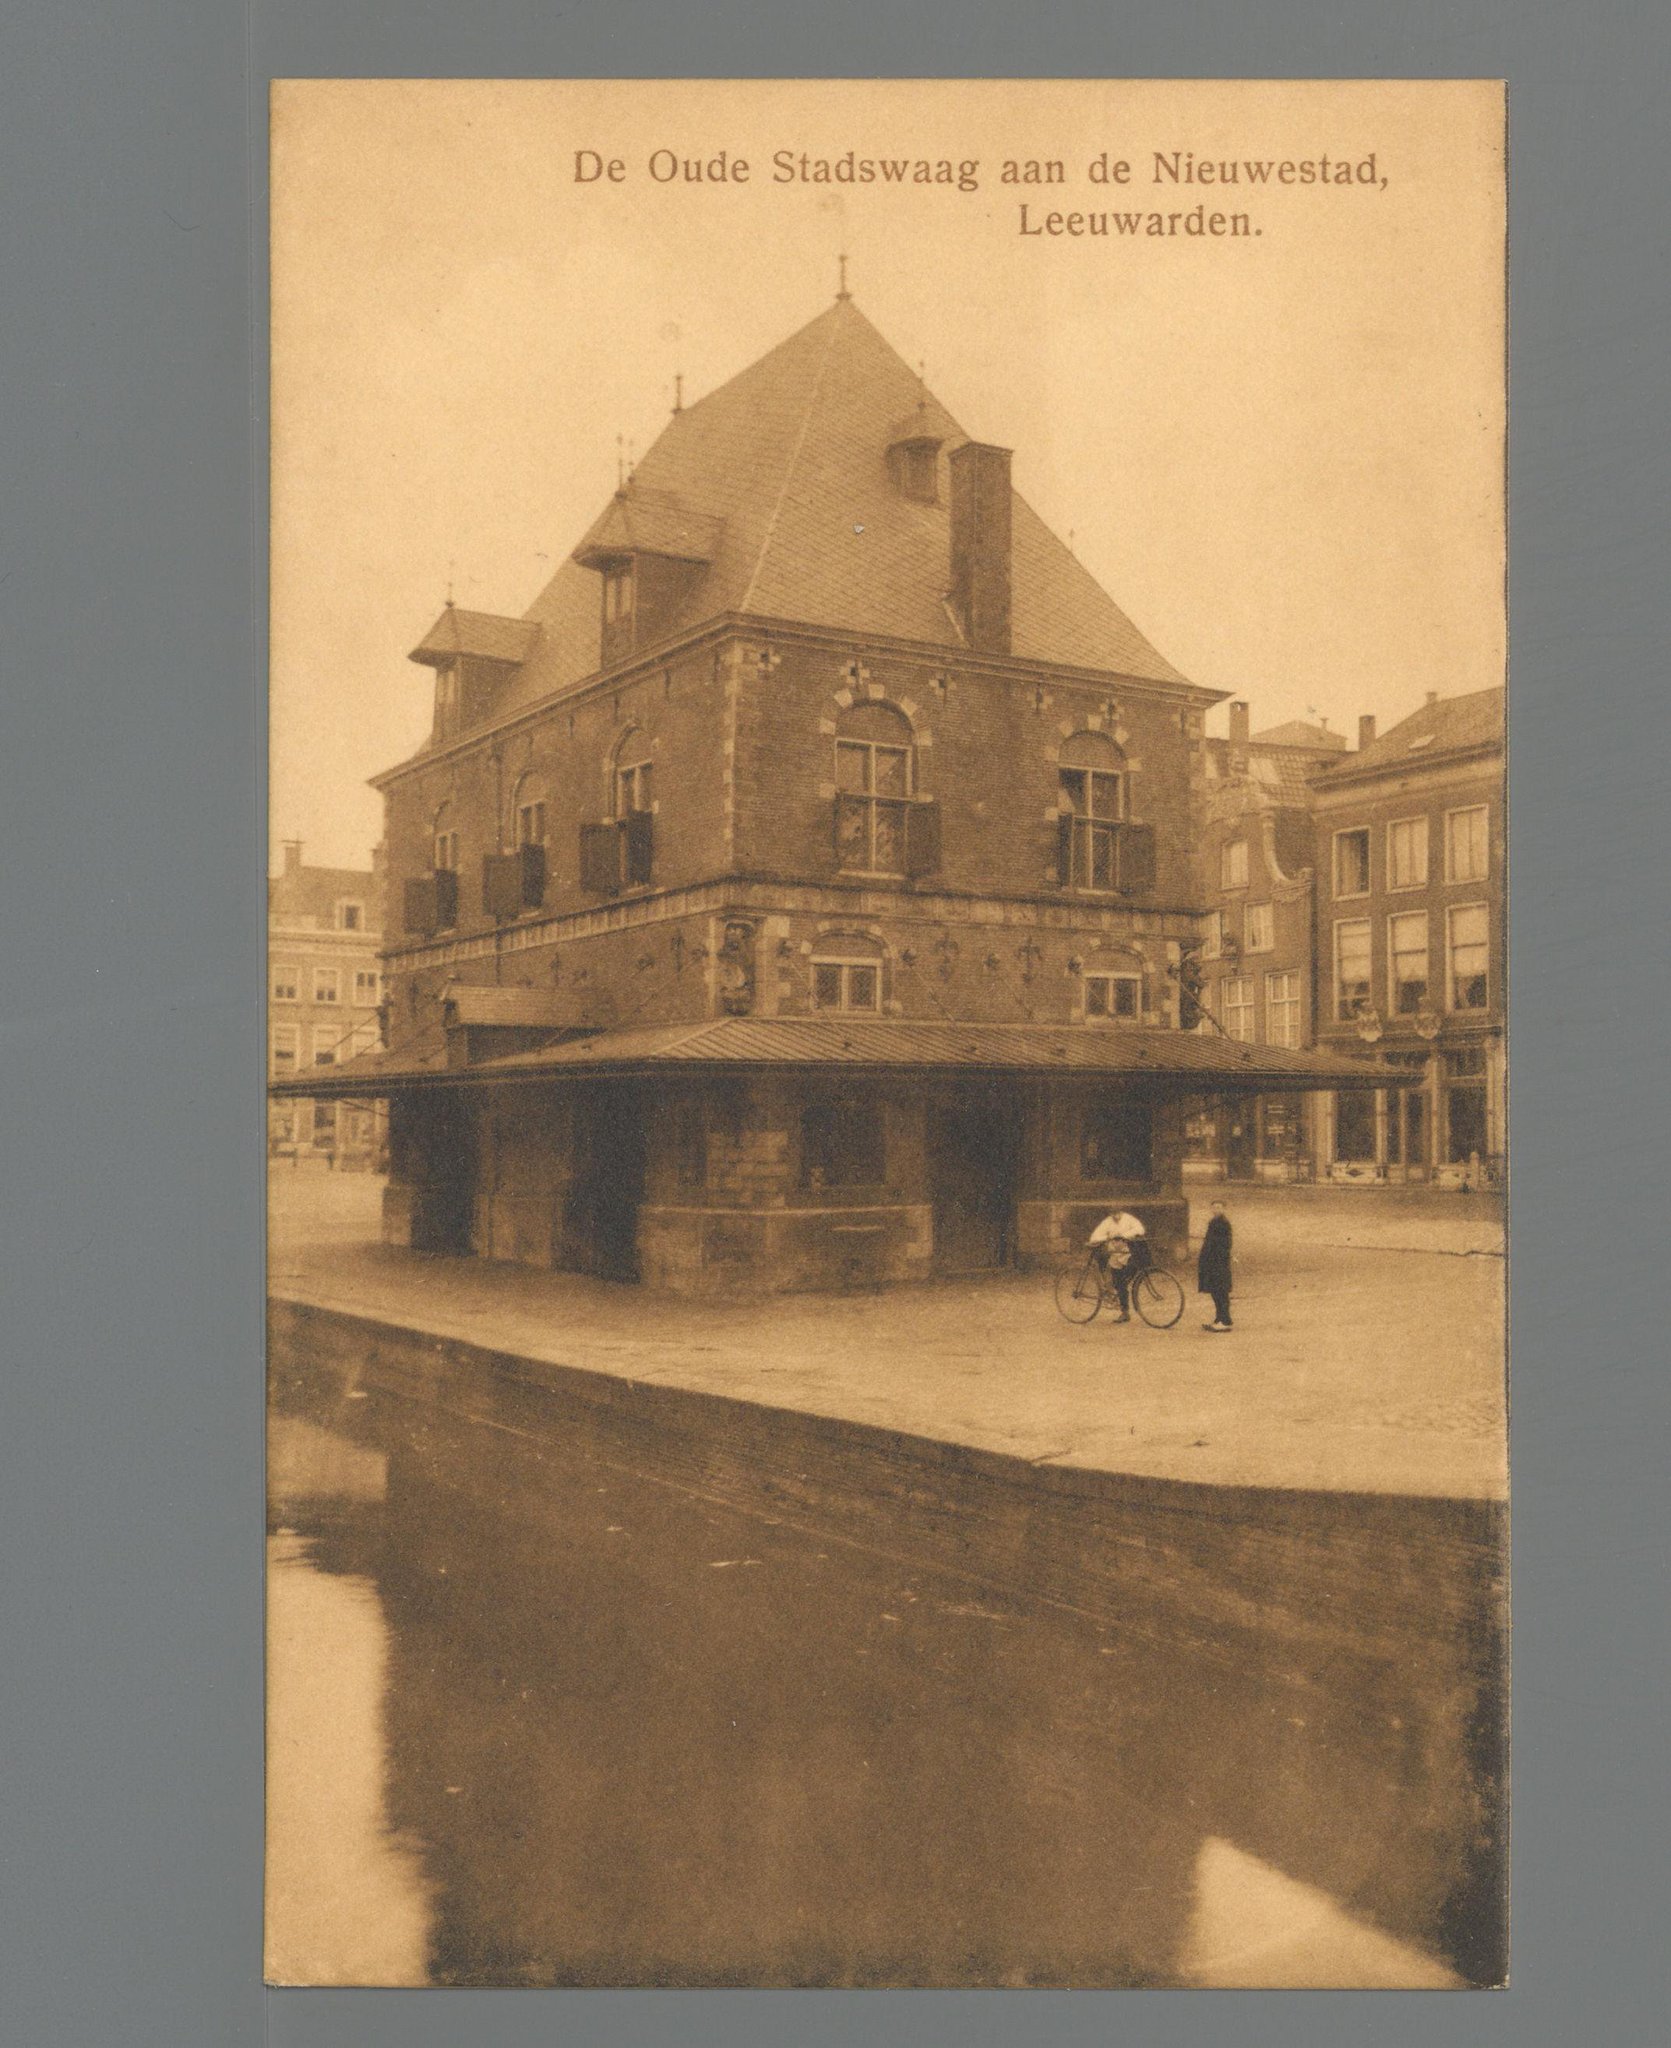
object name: ansichtkaart, prentbriefkaart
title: De Oude Stadswaag aan de Nieuwestad, Leeuwarden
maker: Anonymous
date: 1905-1930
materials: cardboard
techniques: photograph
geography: leeuwarden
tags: city-view, and landscape with man-made constructions, canal, weigh-house